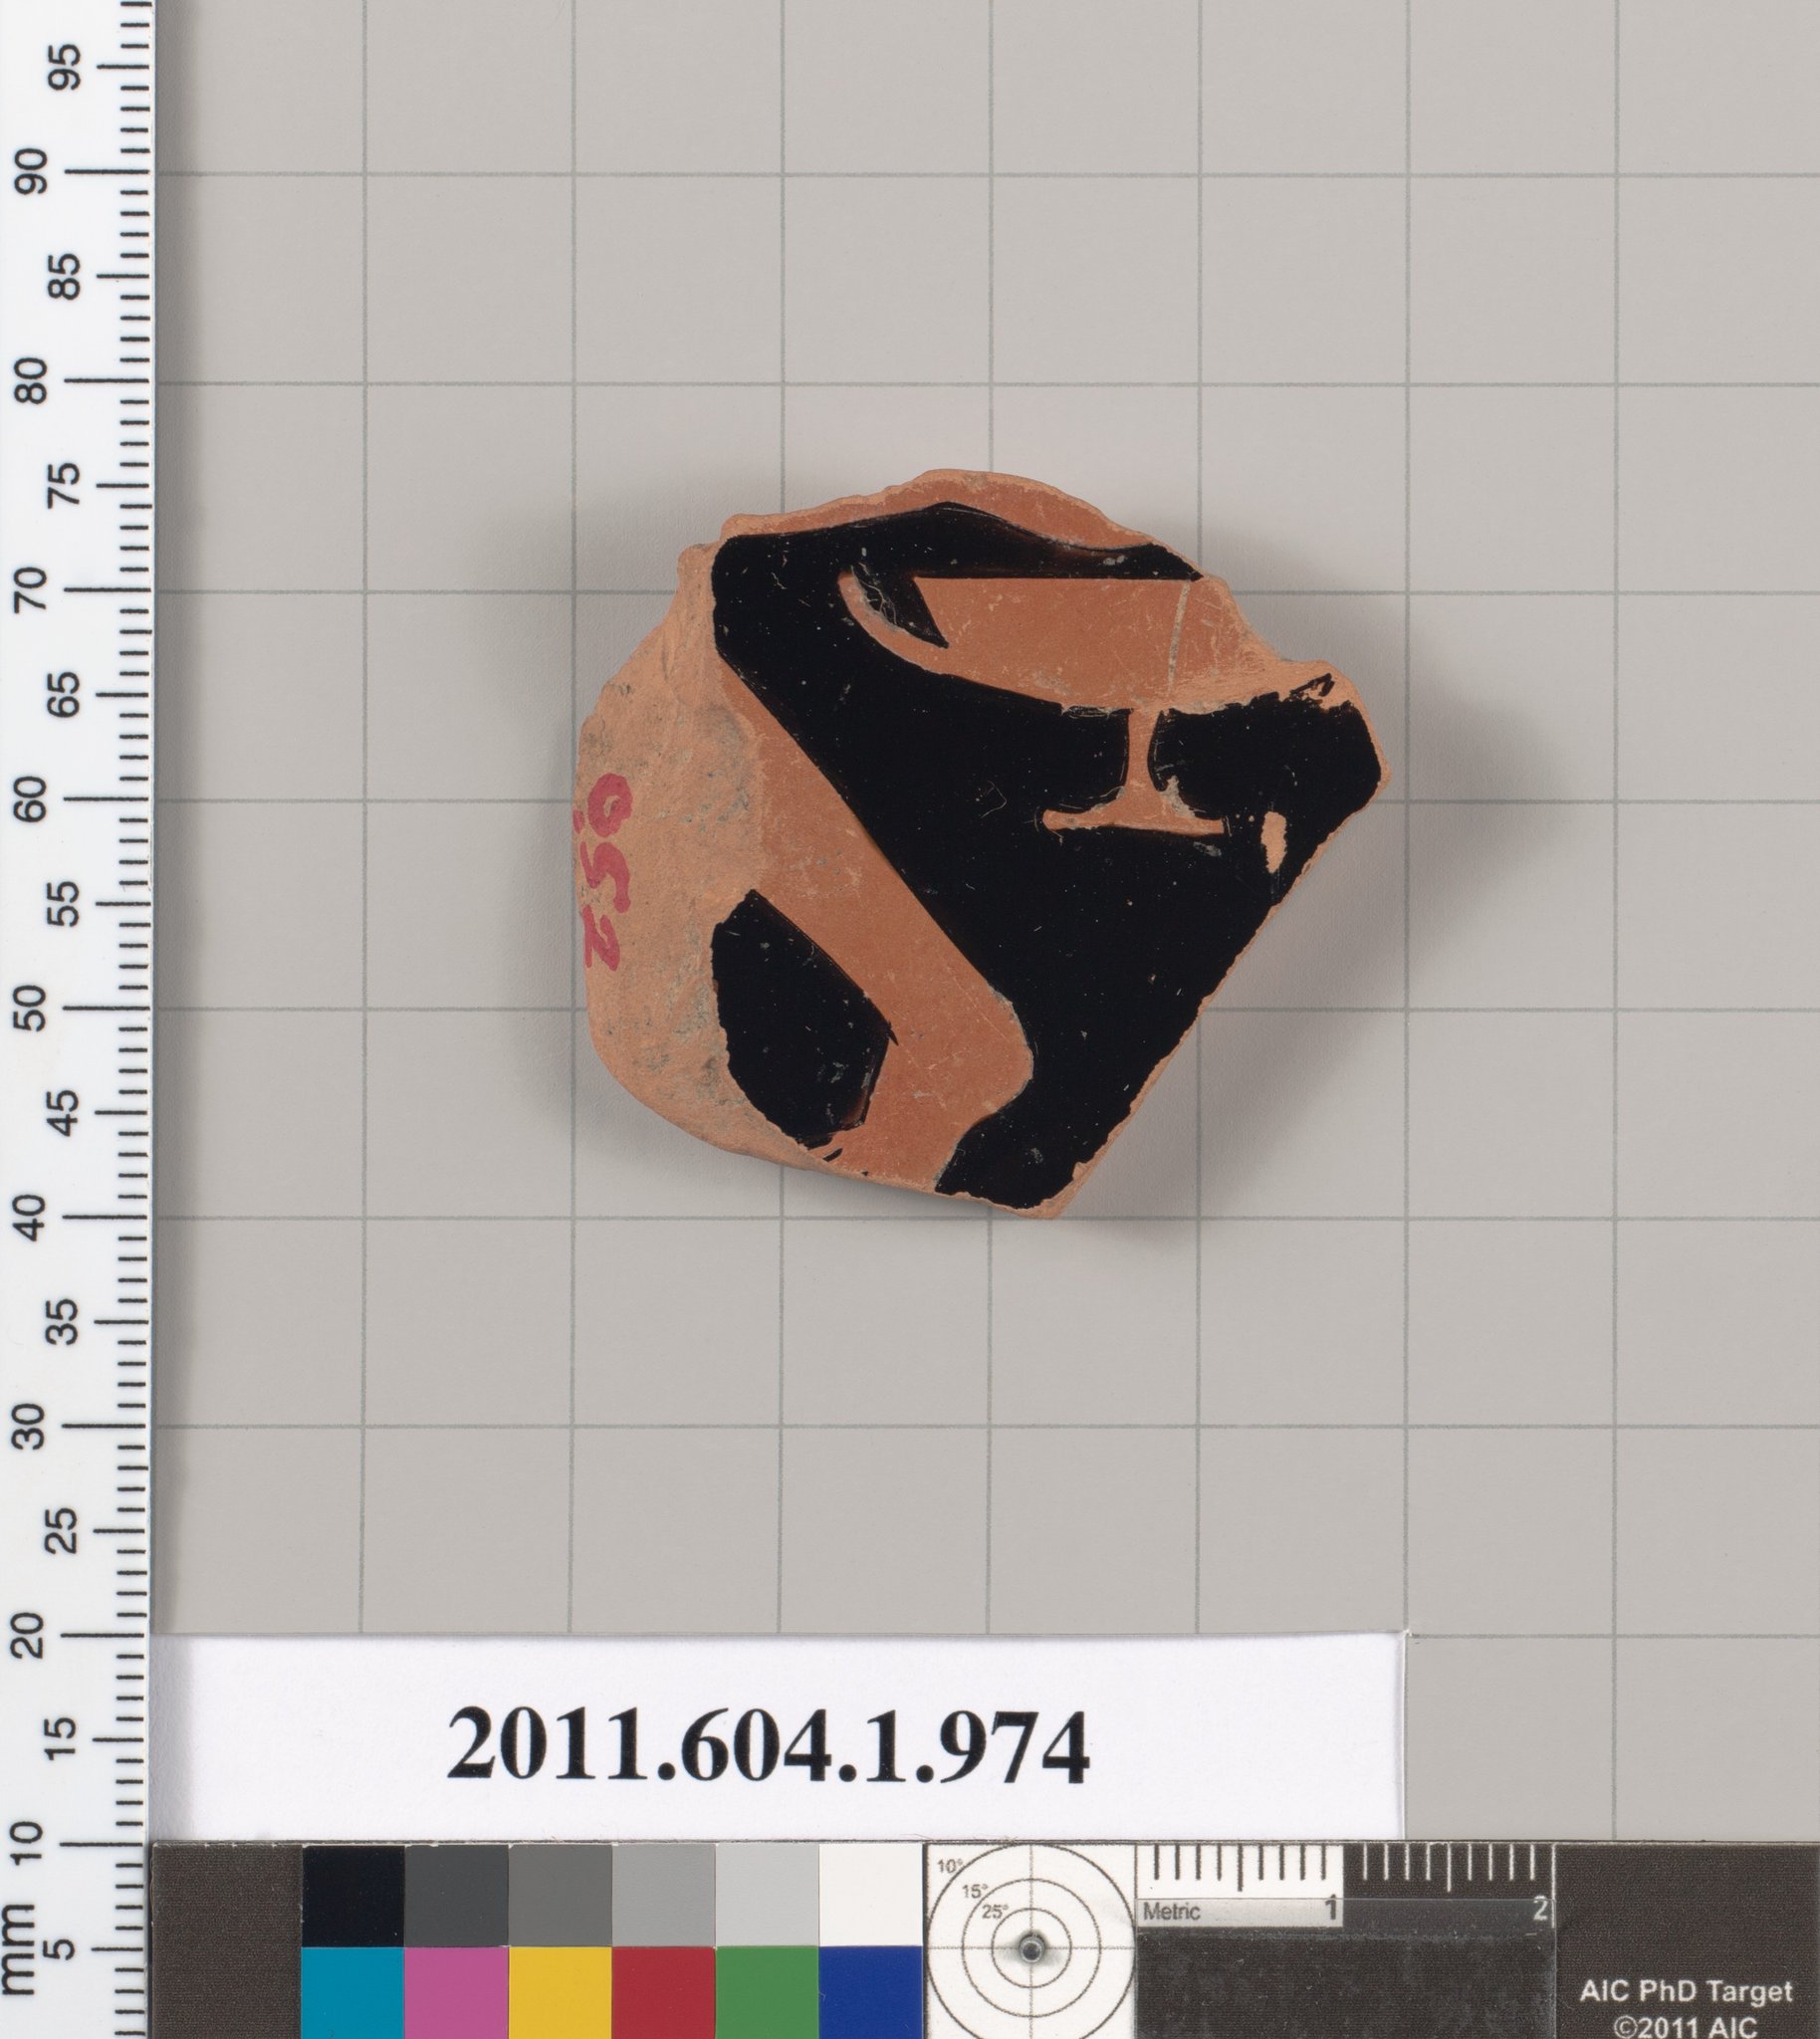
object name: kylix fragment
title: Terracotta fragment of a kylix (drinking cup)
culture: greek, attic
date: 490-480 BCE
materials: terracotta